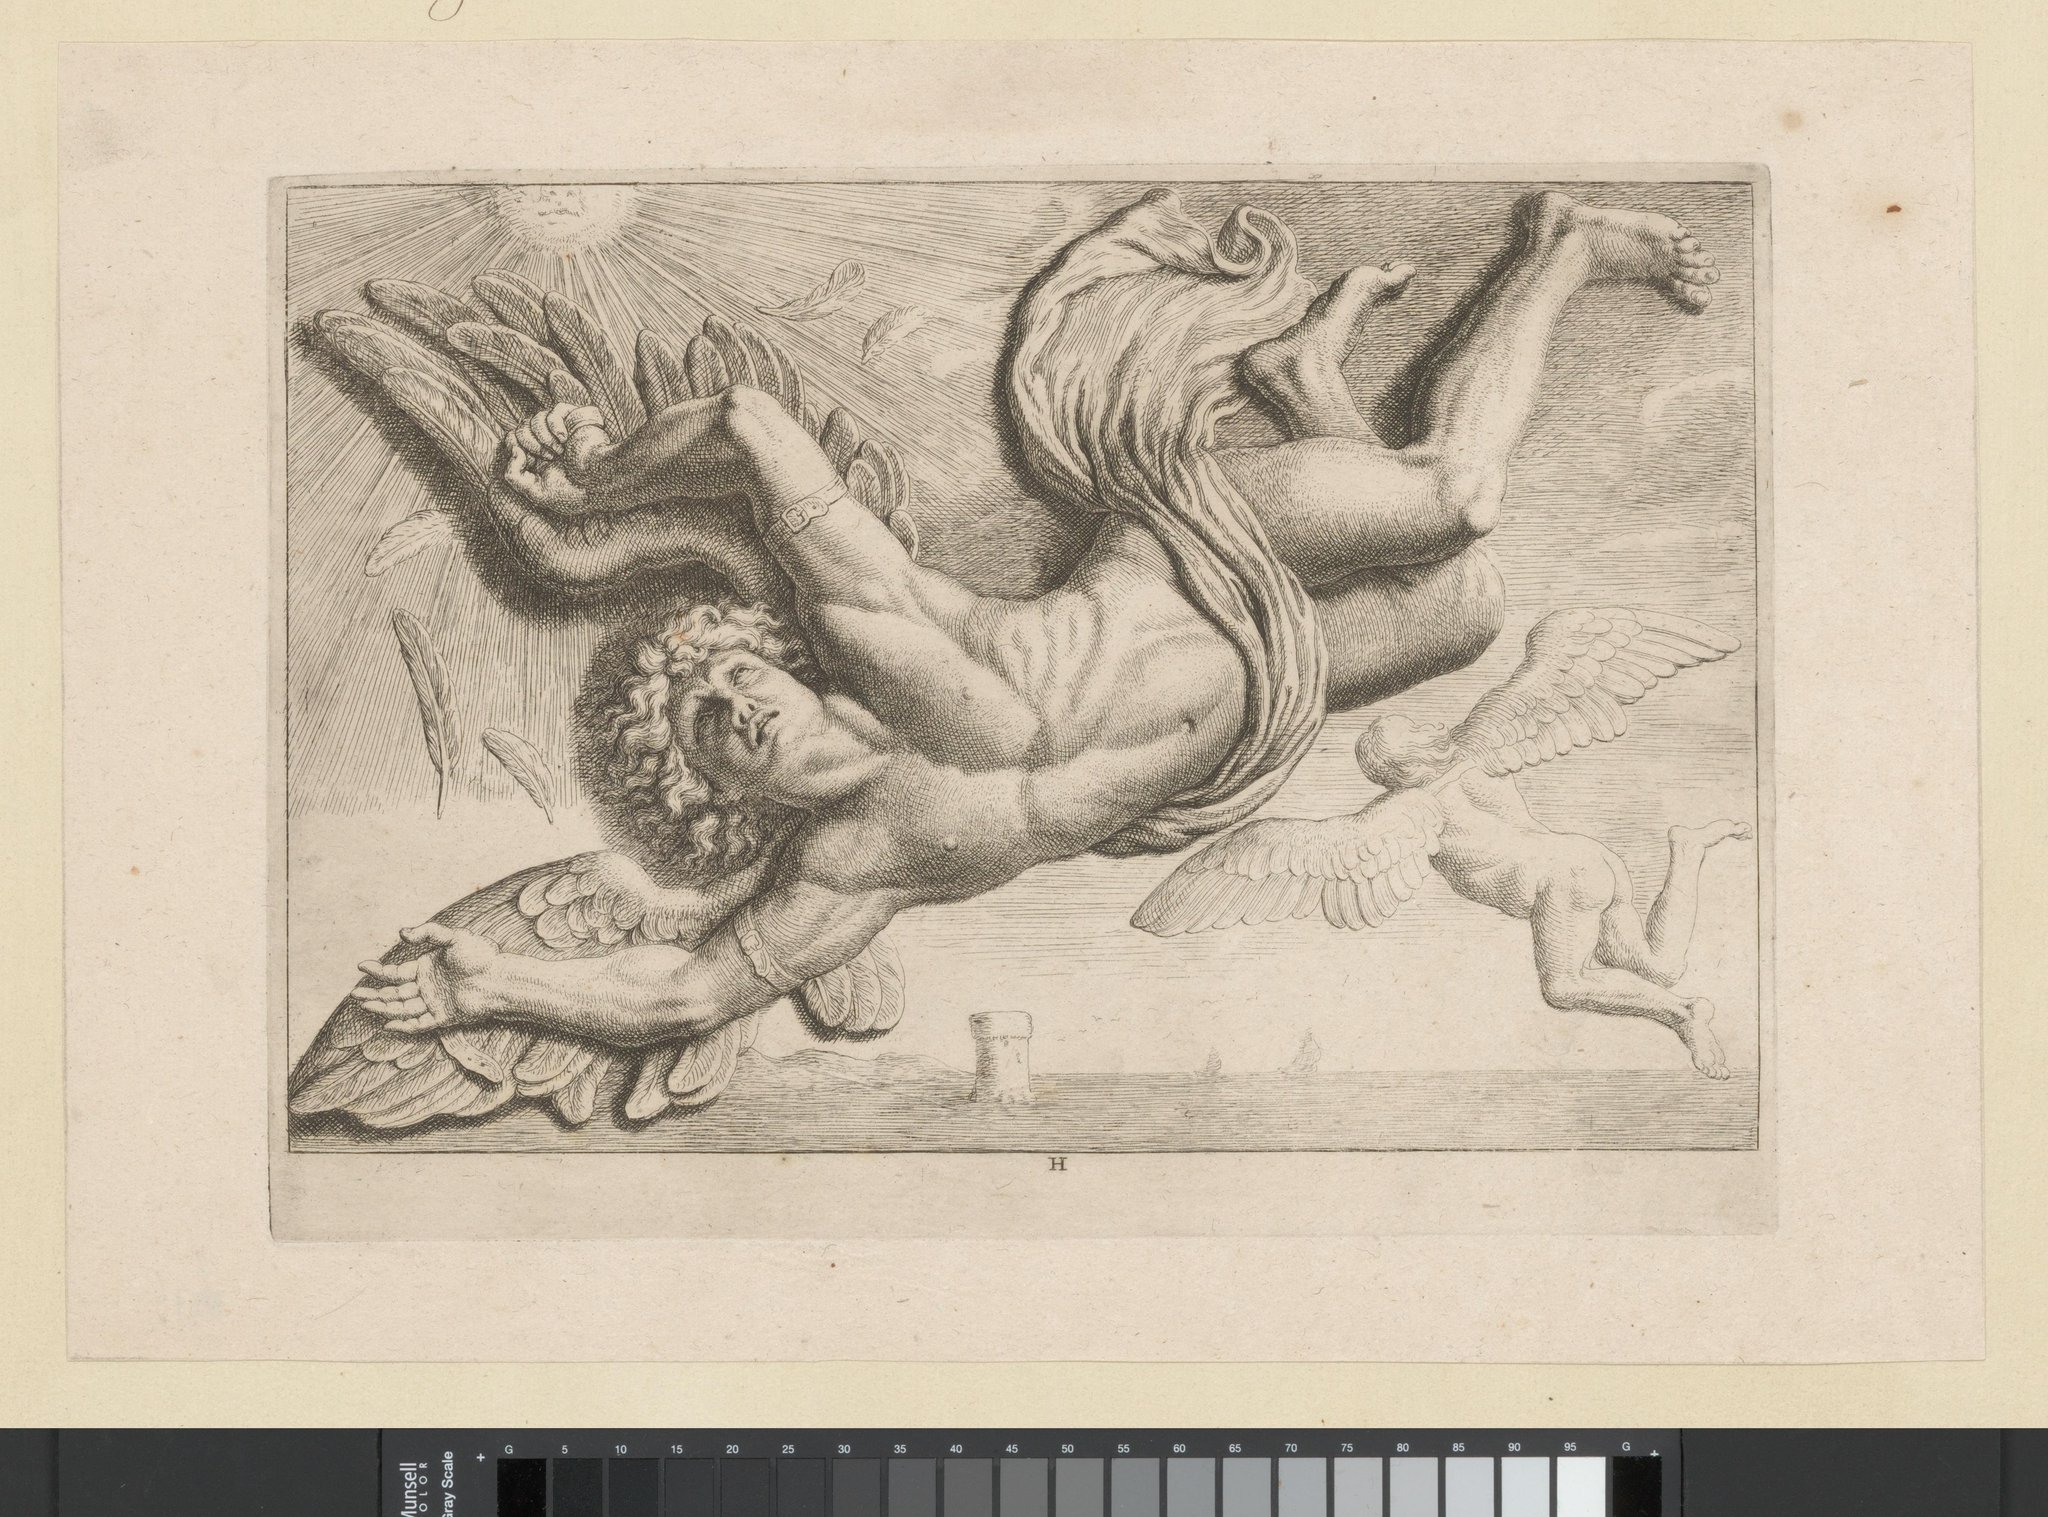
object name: print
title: Reliëf met Arion op de dolfijn boven de deur naar de Assurantiekamer in het Stadhuis op de Dam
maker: hubert quellinus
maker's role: print maker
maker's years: 1619-1687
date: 1663-1668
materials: paper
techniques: engraving, etching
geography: amsterdam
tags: arion rides on a dolphin, holding his lyre, townhall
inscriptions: collector's mark: ‘16,76’ Lugt 1641b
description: Huidige staat van prent ook gebruikt in: Secunca pars Praecipuarum effigierum ac ornamentorum amplissime Curiae Amstelrodamensis maiori ex parte in cadido marmore effectorum per Artum Quellinium eiusdem Civitatis Statuarium / Het tweede deel Van de voornaemste Statuen ende Cieraten van 't konst-rijcke Stadt-huys van Amstelredam 'tmeeste in Marmer gemaeckt door Artus Quellinus Beelthouwer der voorseyde Stadt. Amsterdam: Artus Quellinus (I), 1663. En in: Secunca pars Praecipuarum effigierum ac ornamentorum amplissime Curiae Amstelrodamensis maiori ex parte in cadido marmore effectorum per Artum Quellinium eiusdem Civitatis Statuarium / Het tweede deel Van de voornaemste Statuen ende Cieraten van 't konst-rijcke Stadt-huys van Amstelredam 'tmeeste in Marmer gemaeckt door Artus Quellinus Beelthouwer der voorseyde Stadt. Amsterdam: Frederik de Wit, 1668. Latere staat van prent ook gebruikt in: Architecture peinture et sculpture de la Maison de Ville d'Amsterdam, representee en CIX. figures en taille-douce (…). Amsterdam: David Mortier, 1719. En in: Architecture peinture et sculpture de la Maison de Ville d'Amsterdam, representee en CIX. figures en taille-douce (…). Amsterdam: Gerard Valck, 1719. En in: Bouw schilder en beeldhouwkonst, van het Stadhuis te Amsteldam, vertoont in CIX figuuren (…). Amsterdam: Covens & Mortier & Covens Jr., s.a. (1774-1783).